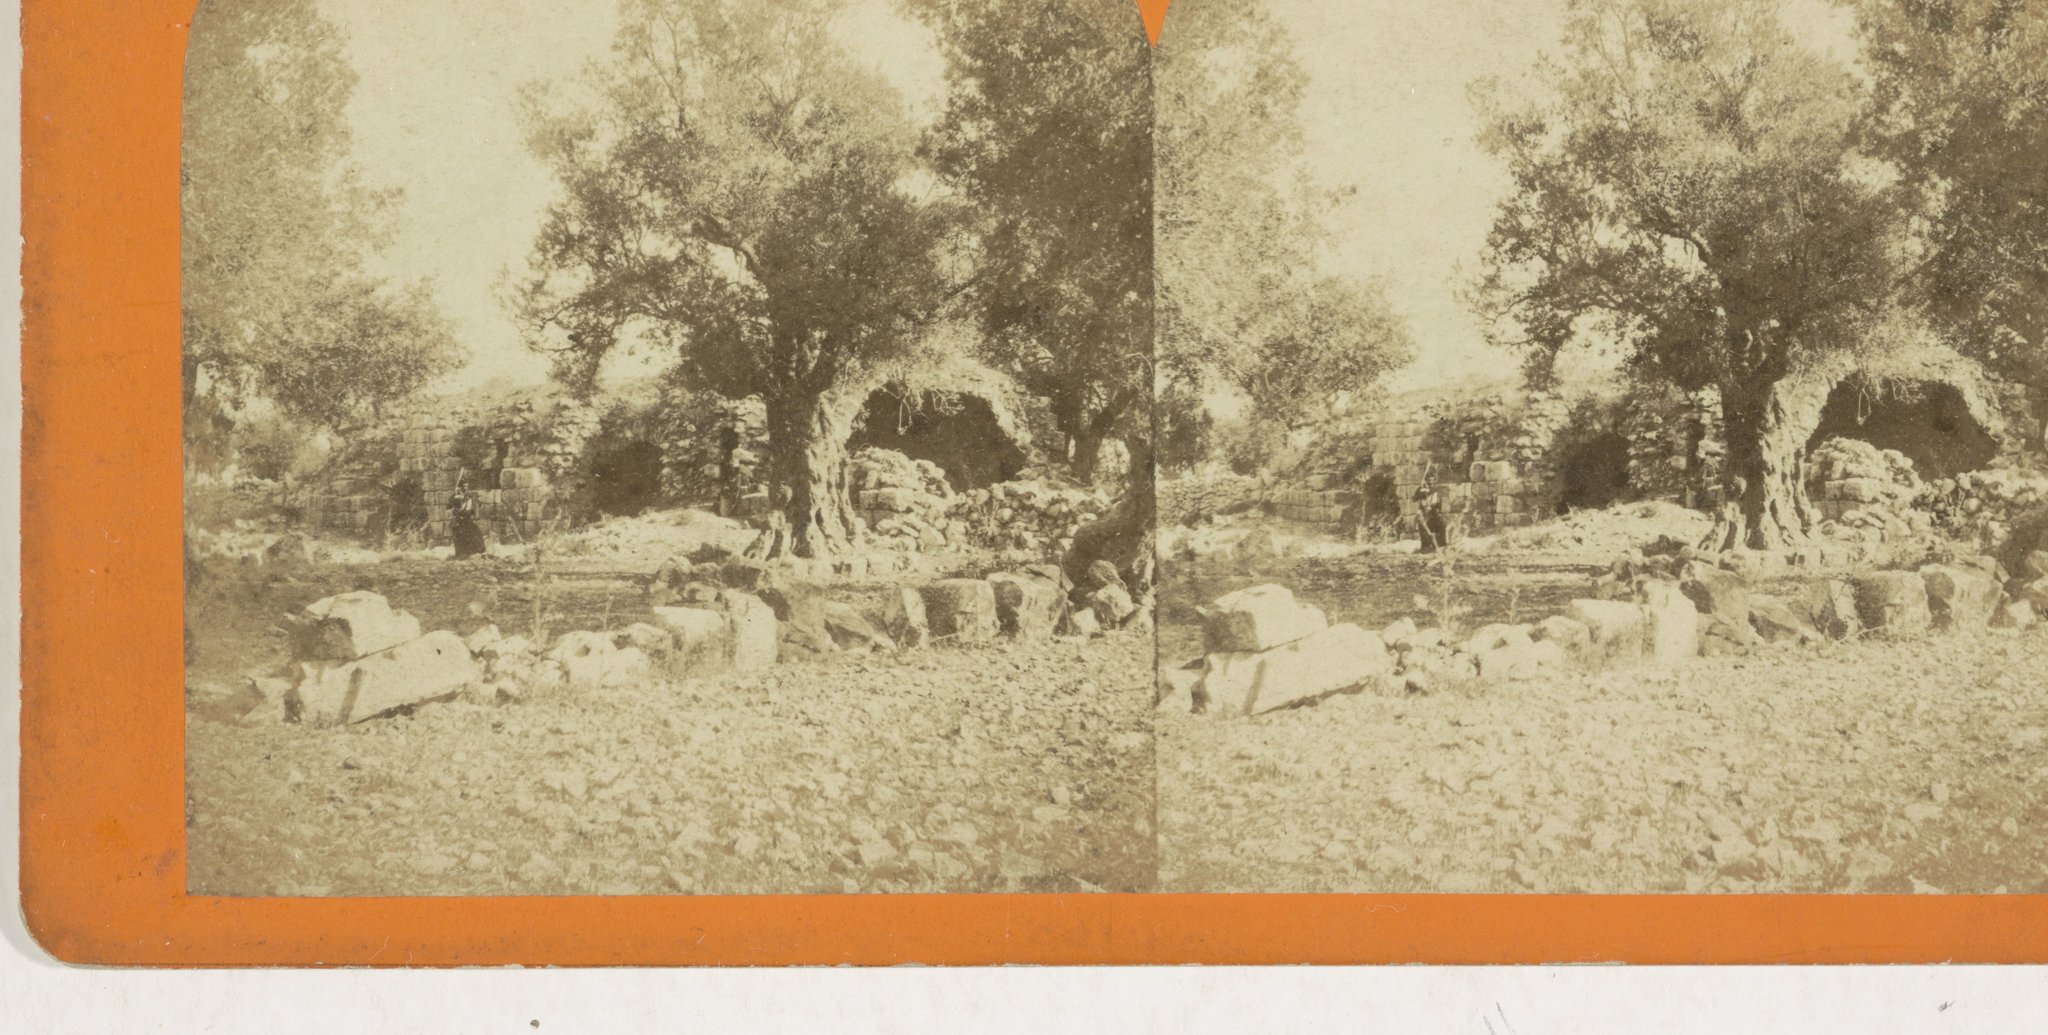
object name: stereograph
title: Ruïnes van Emmaus Nicopolis, Israël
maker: Anonymous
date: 1868-1890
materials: cardboard, paper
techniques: albumen print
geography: emmaus nicopolis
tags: landscape with ruins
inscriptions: monogram